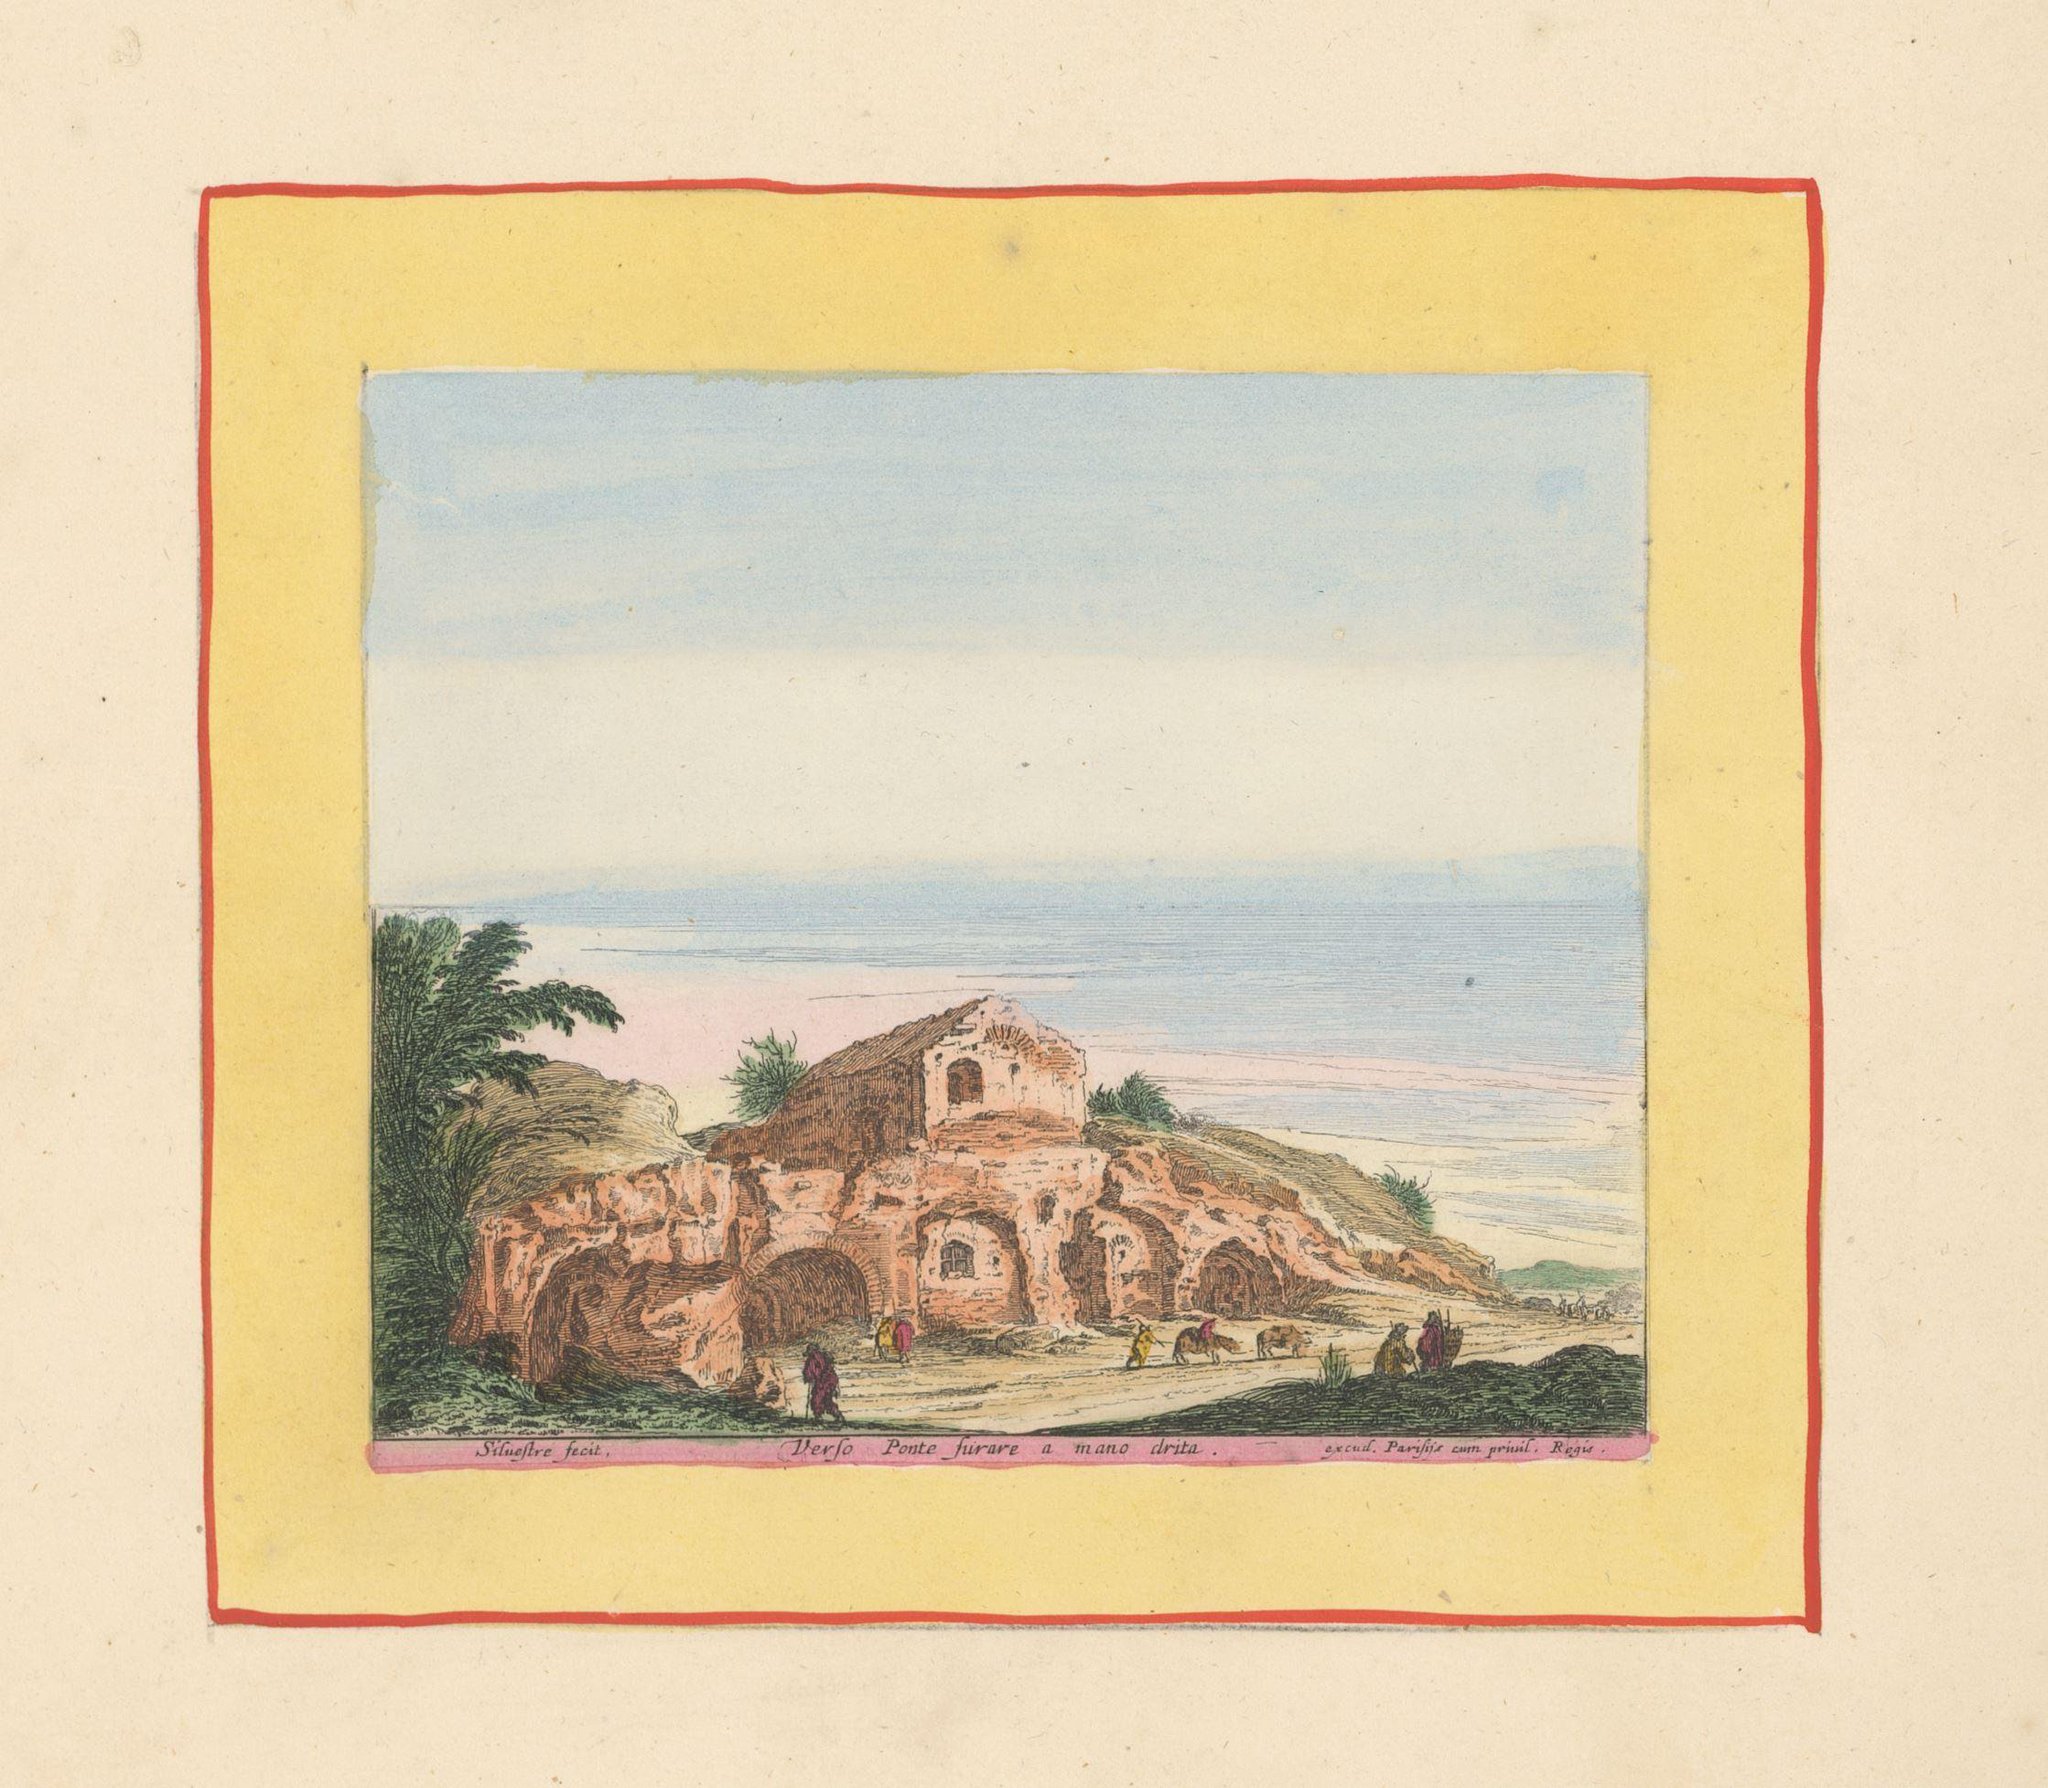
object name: album leaf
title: Antieke en moderne monumenten in Rome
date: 1631-1691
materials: paper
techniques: colour, etching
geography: paris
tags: ruin of a building ~ architecture, landscape with ruins, rome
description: Prent maakt deel uit van een reeks van twaalf prenten van gezichten op antieke en moderne monumenten in Rome. De prent is langs de bovenrand van de voorstelling afgescheurd. De voorstelling is aan de bovenzijde aangevuld met een geschilderde lucht.